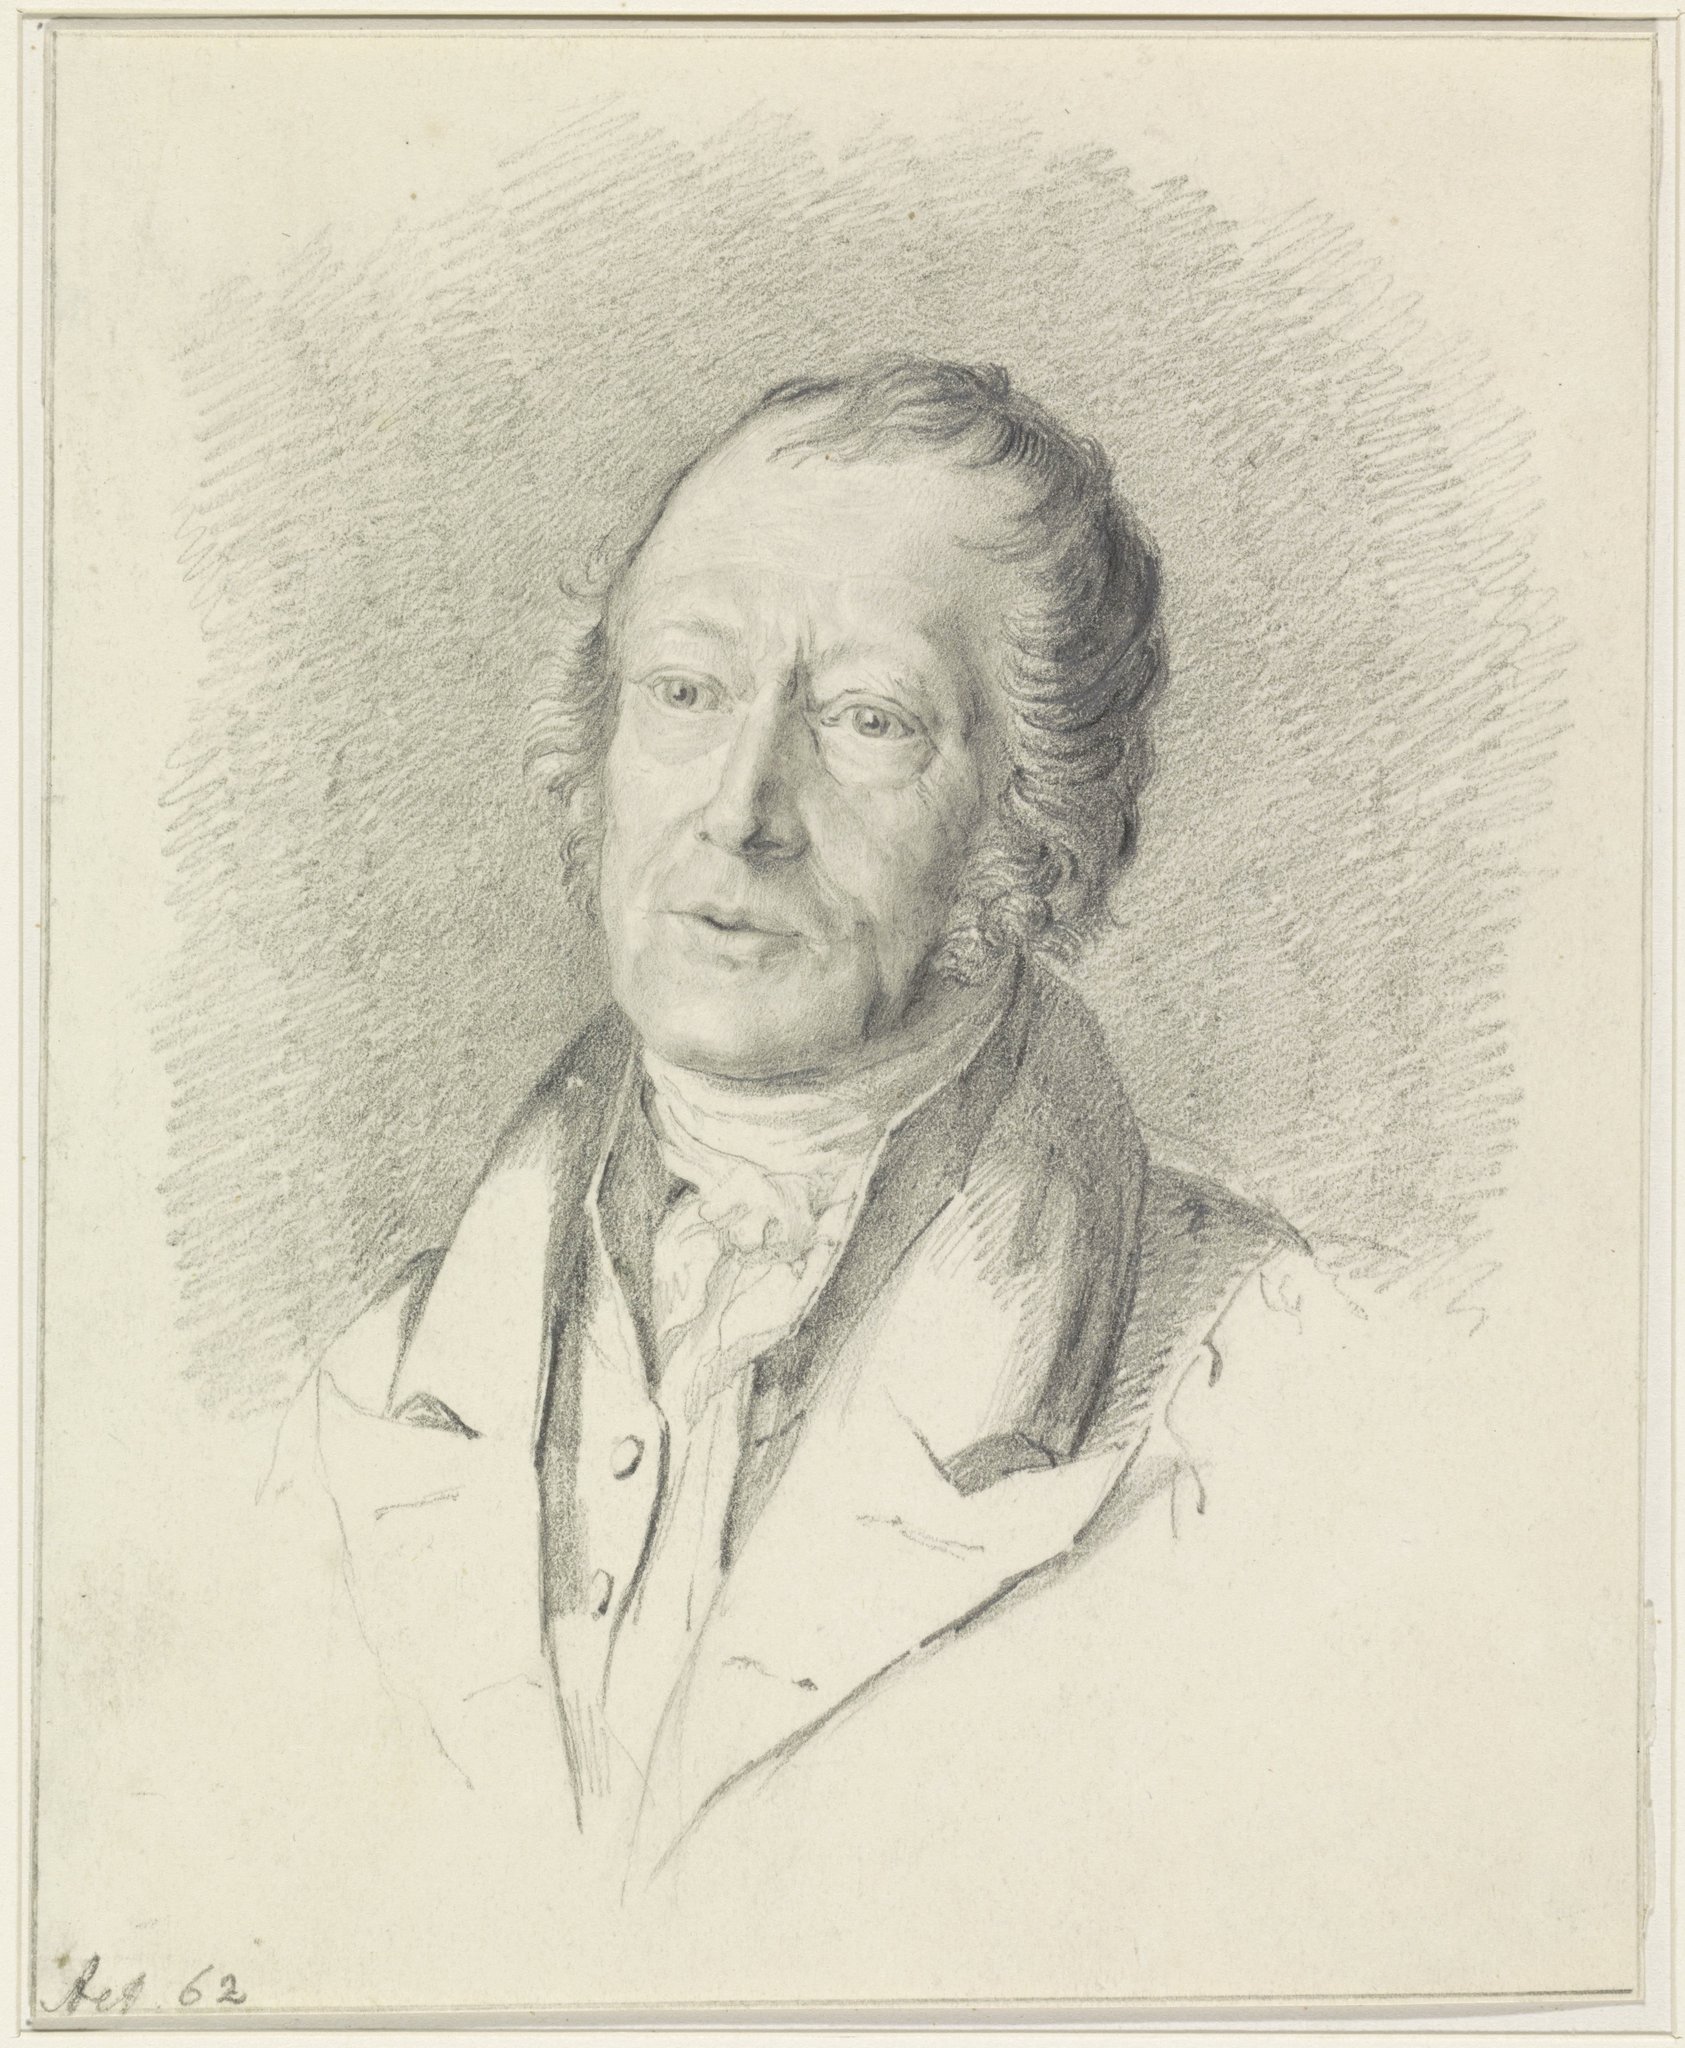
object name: drawing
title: Portret van Gerrit Lamberts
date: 1830-1862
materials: paper, pencil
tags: amsterdam, print maker, draughtsman, bookseller, gerrit lamberts, historical persons, portrait, self-portrait of artist